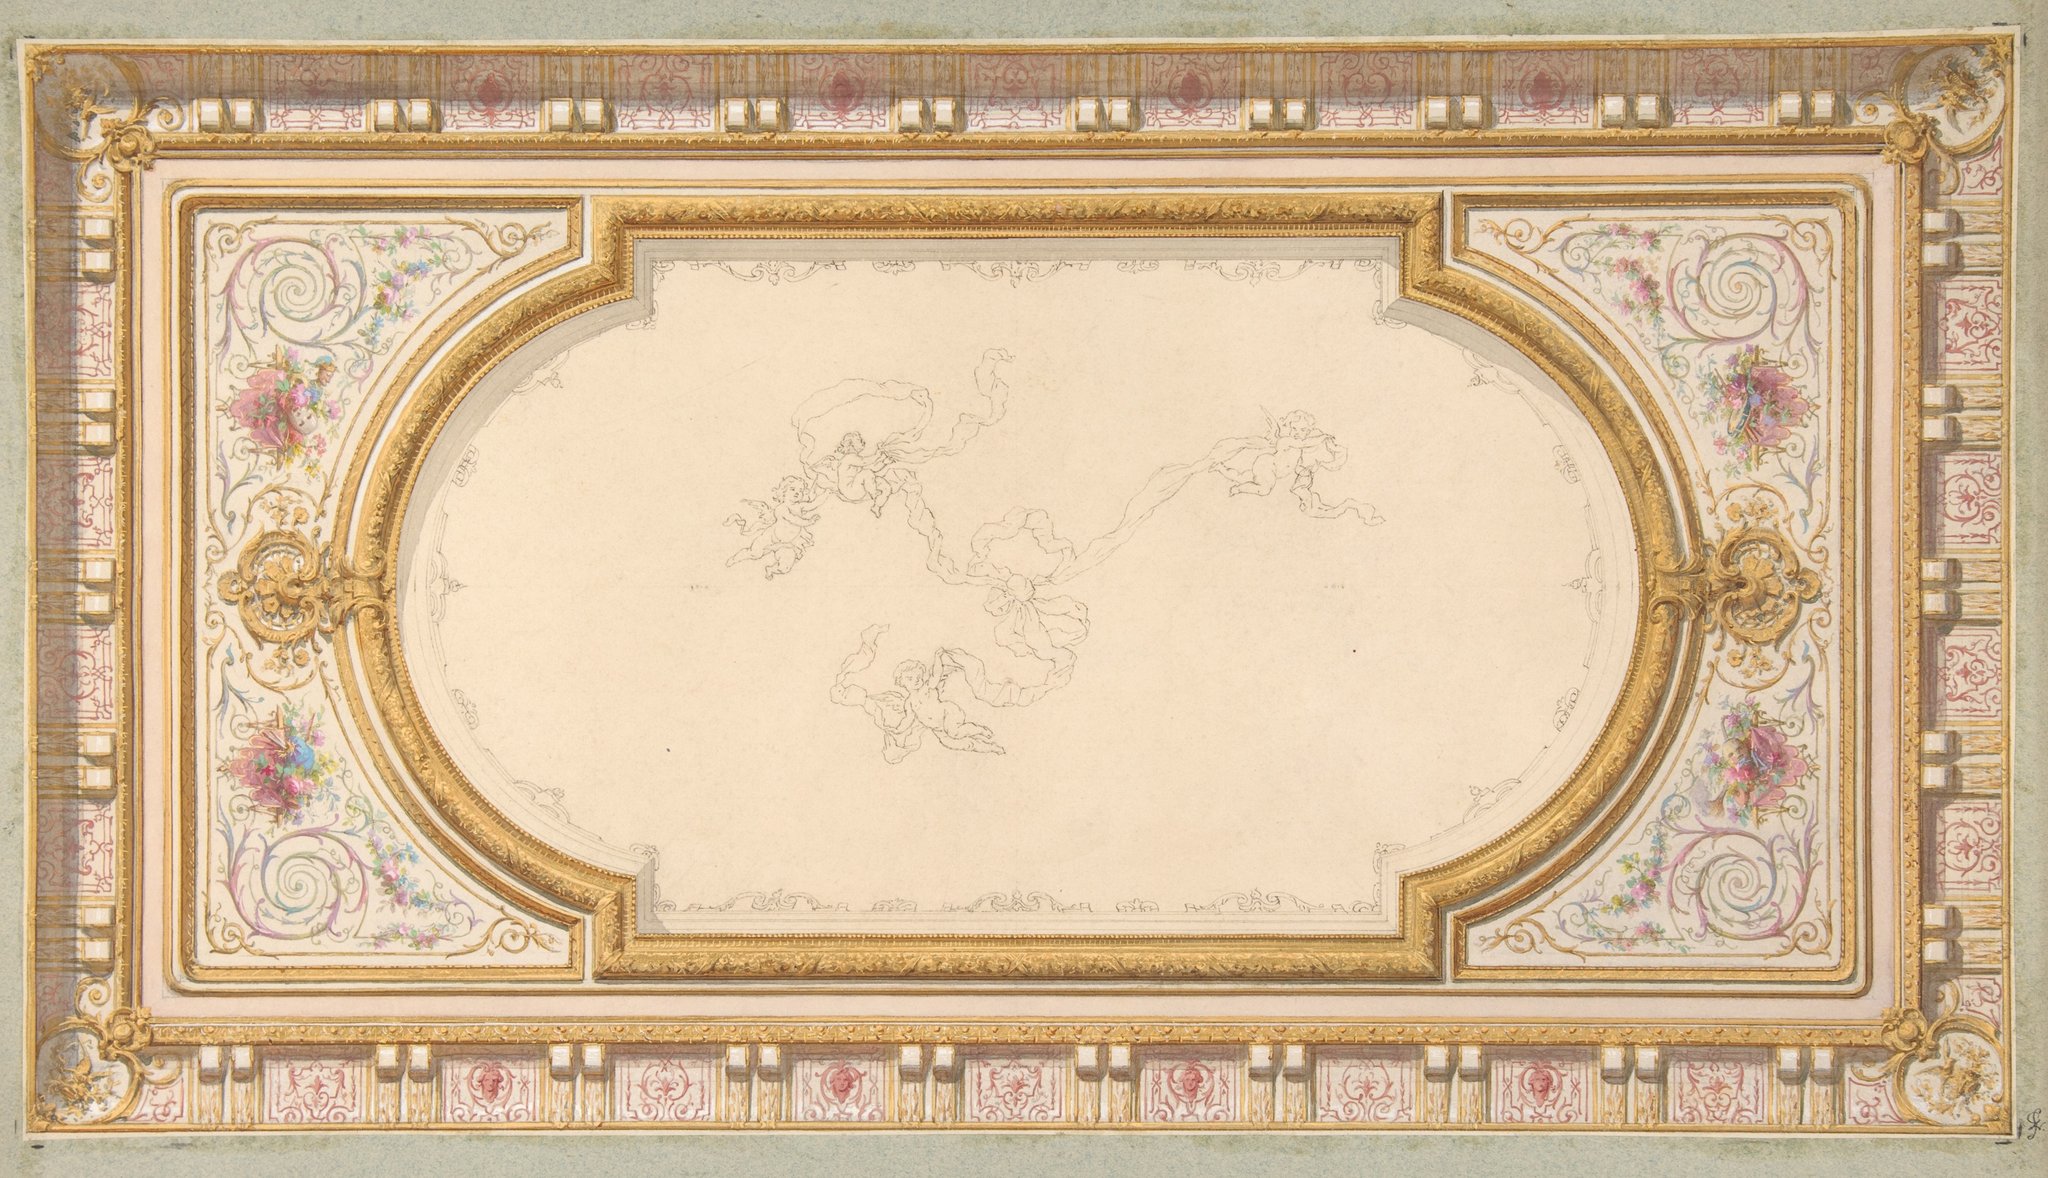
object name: drawing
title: Design for a ceiling with ribbon bearing putti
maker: jules-edmond-charles lachaise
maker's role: artist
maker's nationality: french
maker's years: 1897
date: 1851-1900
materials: gilt, gouache, graphite, ink, watercolor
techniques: pen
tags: putti,ceilings